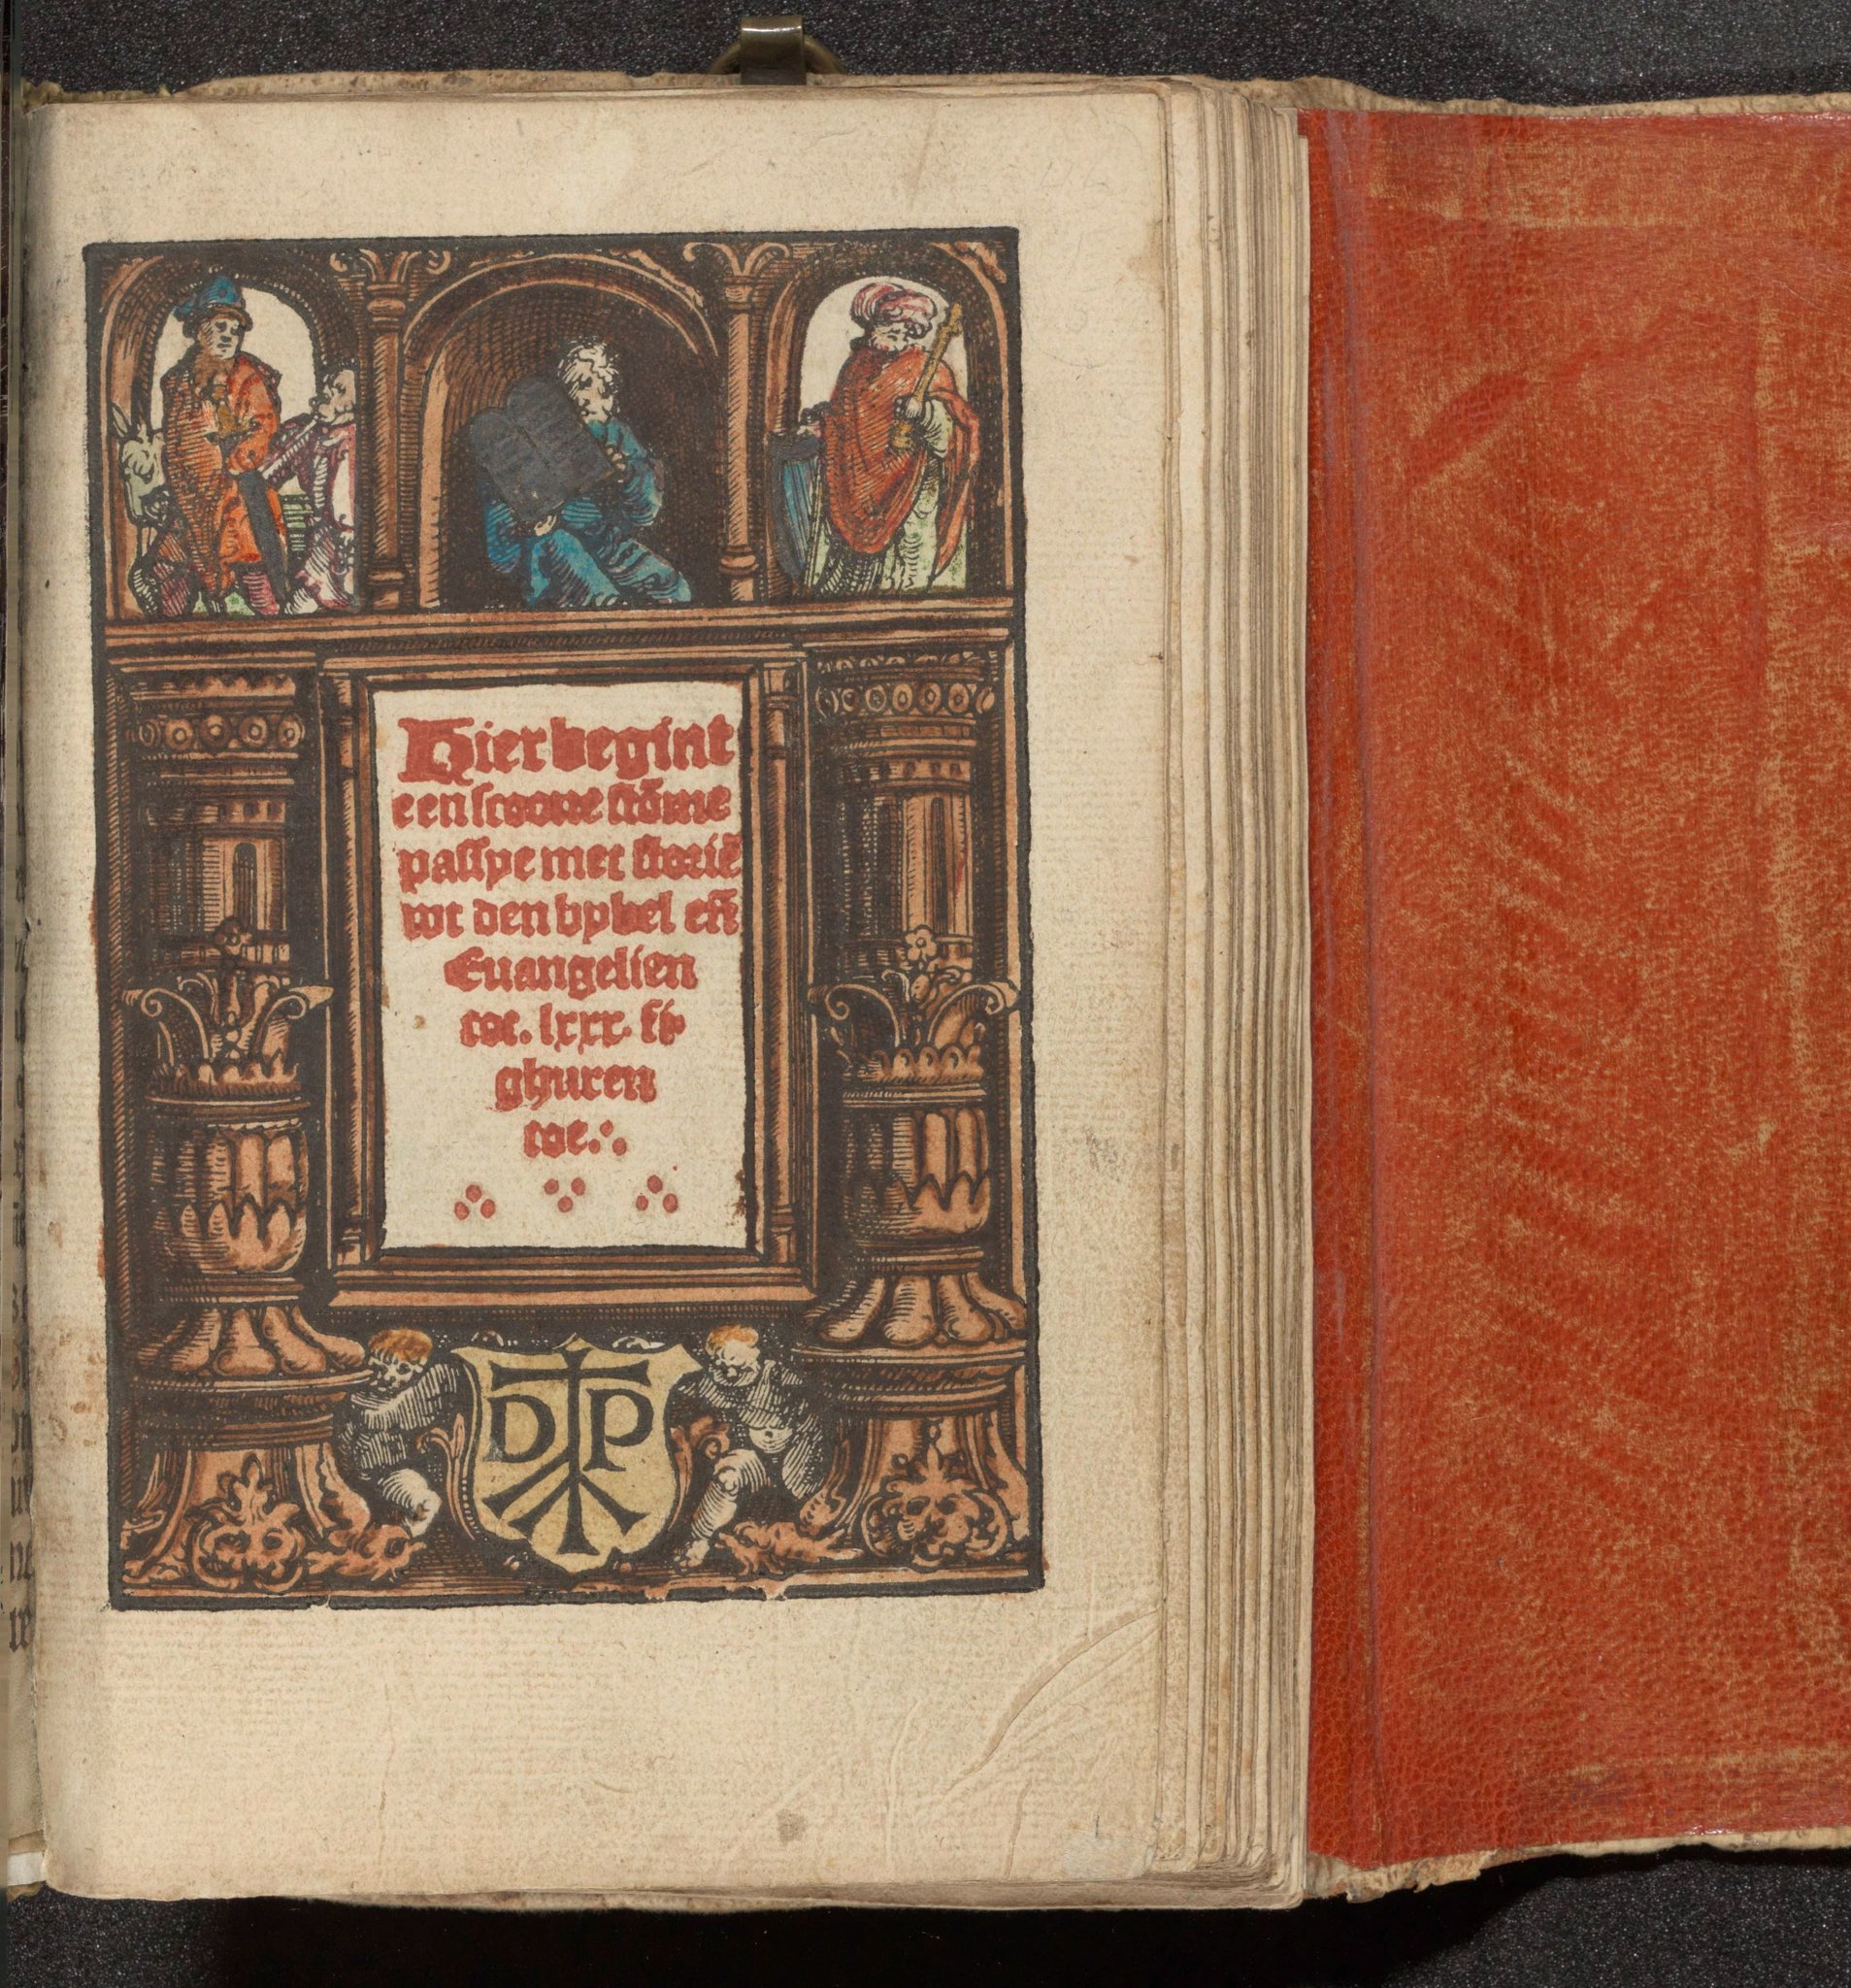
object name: print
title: Stomme Passie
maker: doen pietersz.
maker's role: publisher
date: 1530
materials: paper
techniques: hand coloring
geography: amsterdam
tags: ornaments ~ art, david (not in biblical context); possible attributes: crown, harp, book in which illustrations are essential, moses (not in biblical context); possible attributes: rays of light or horns on his head, rod, tables of the law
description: Bovenaan drie figuren uit het Oude Testament. Links een man met zwaard en ezel (Bileam?), in het midden Mozes met de tafelen der wet en rechts koning David met de harp. Links en rechts van de omlijsting met de titel zuilen. Onderaan tonen twee putti een wapenschild met het drukkersmerk van Doen Pietersz.. Prent maakt deel uit van een boek.